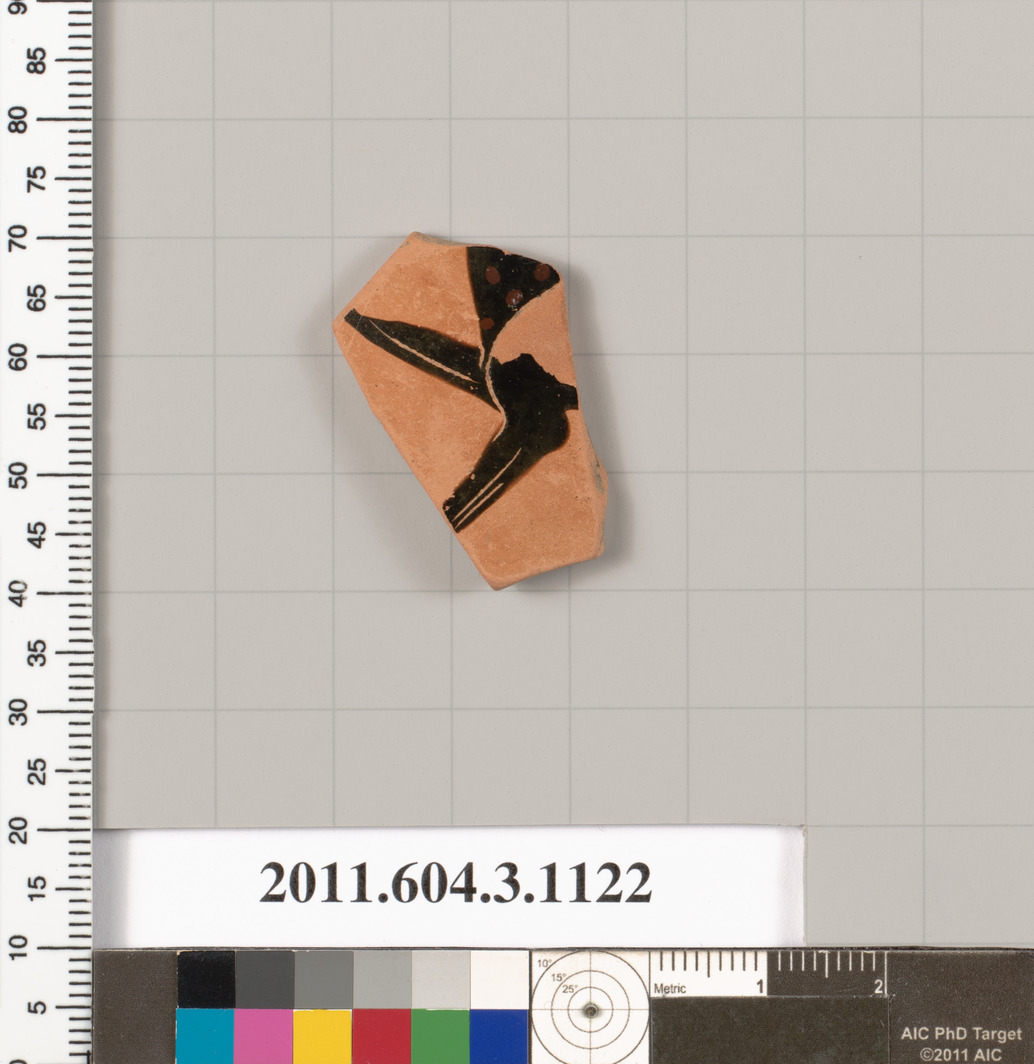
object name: mastoid or kyathos fragment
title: Terracotta fragment of a mastoid (drinking cup with narrow base) or a kyathos (cup-shaped ladle)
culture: greek, attic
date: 534-468 BCE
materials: terracotta